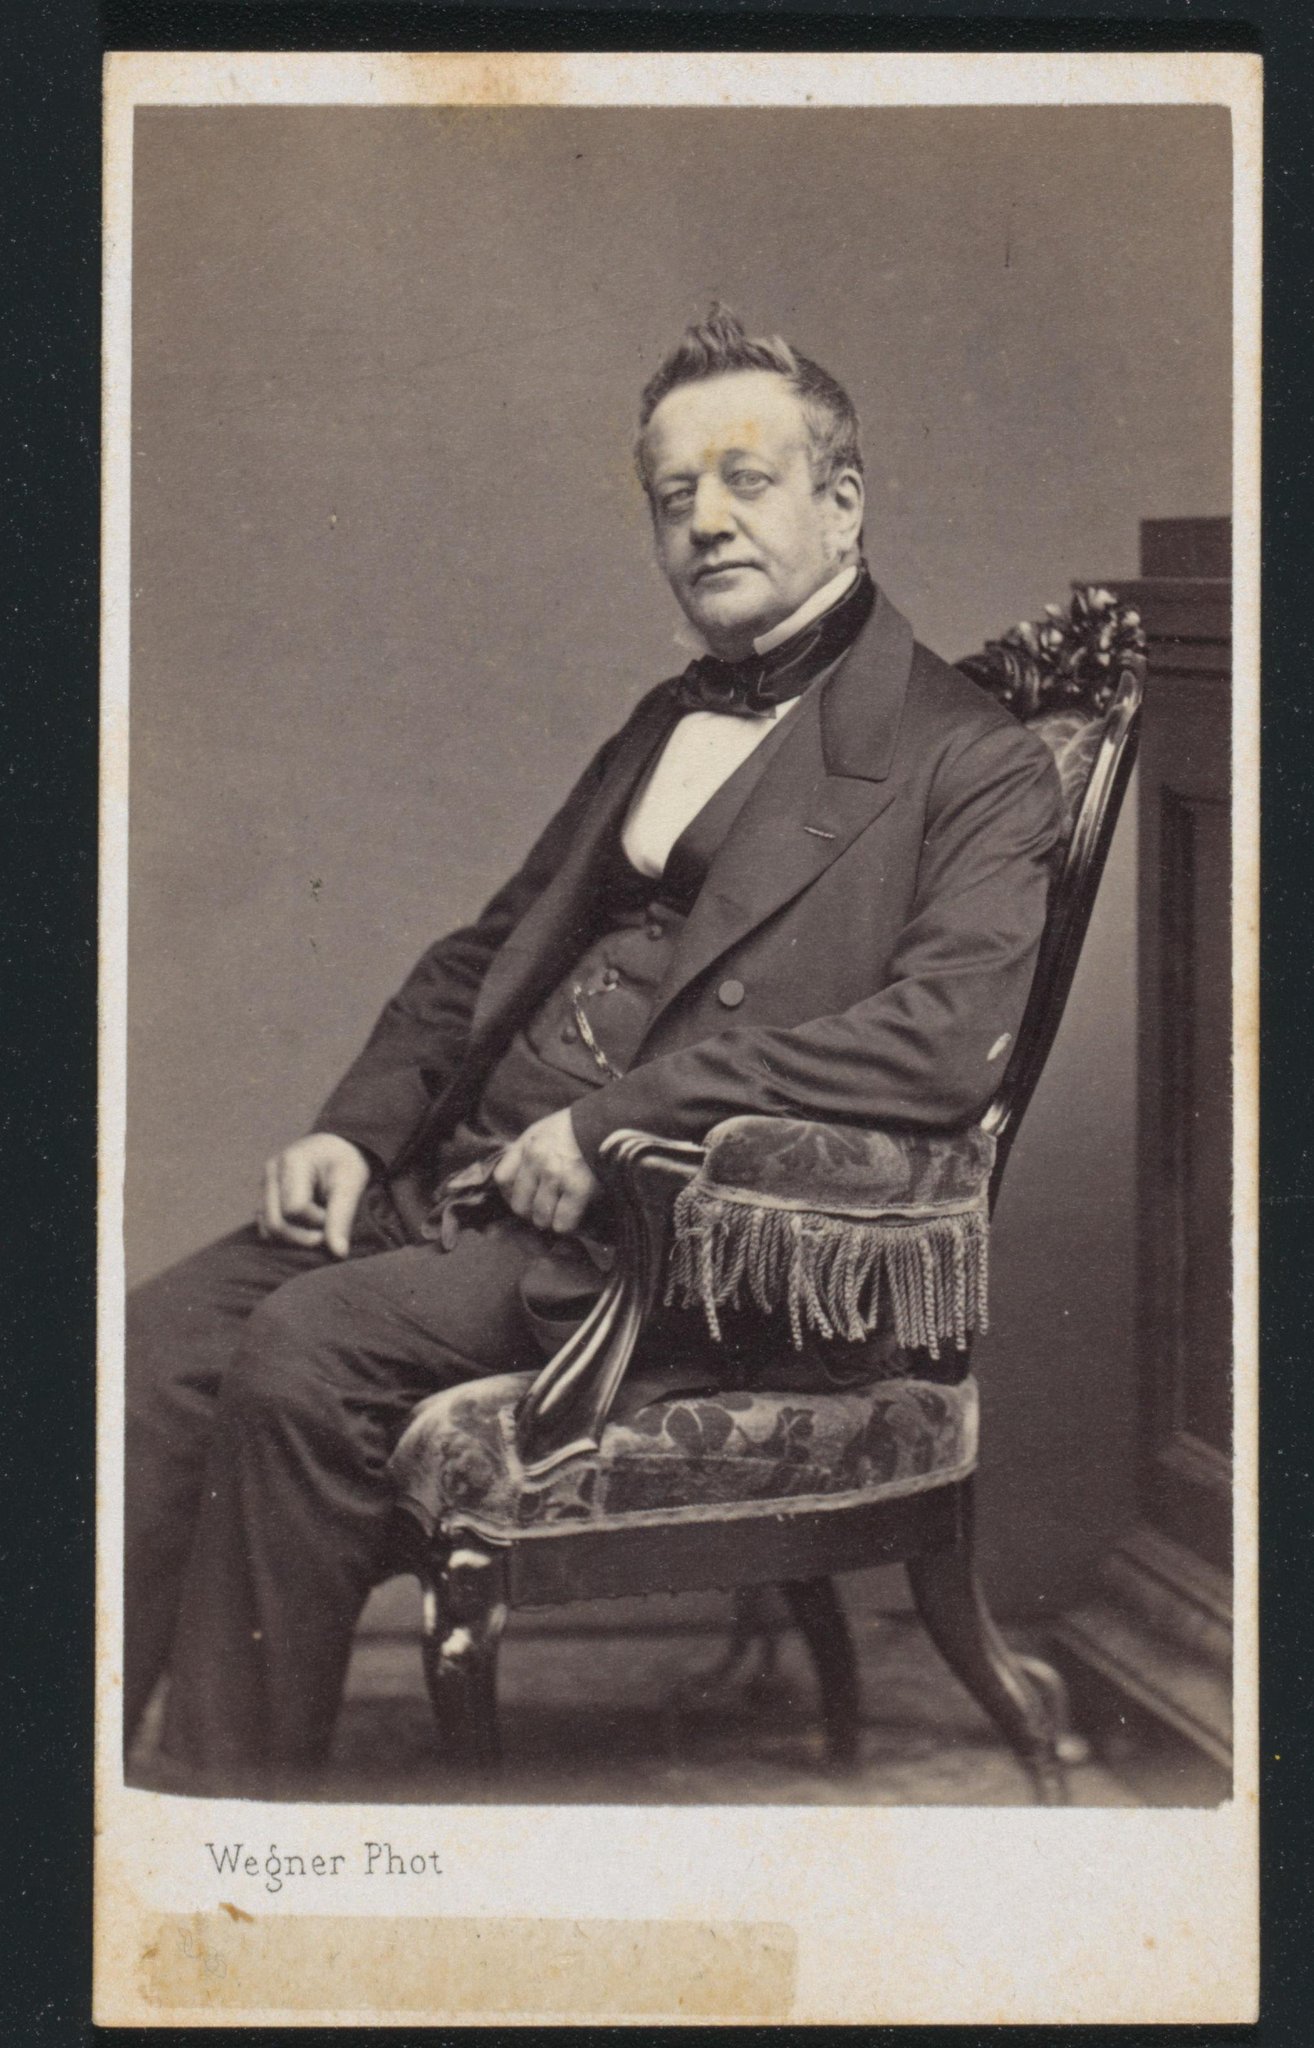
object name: carte de visite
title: Portret van de heer P.J. Teding van Berkhout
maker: louis wegner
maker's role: print maker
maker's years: 1816-1864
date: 1860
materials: cardboard, photographic support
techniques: albumen print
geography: amsterdam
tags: historical persons, coat, cape, amsterdam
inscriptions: inscription: ‘P.J. Teding van Berkhout ± 1860 geb. 14.4.1810 overl. 1892’, address: ‘Prinsengracht BB 439 Amsterdam’